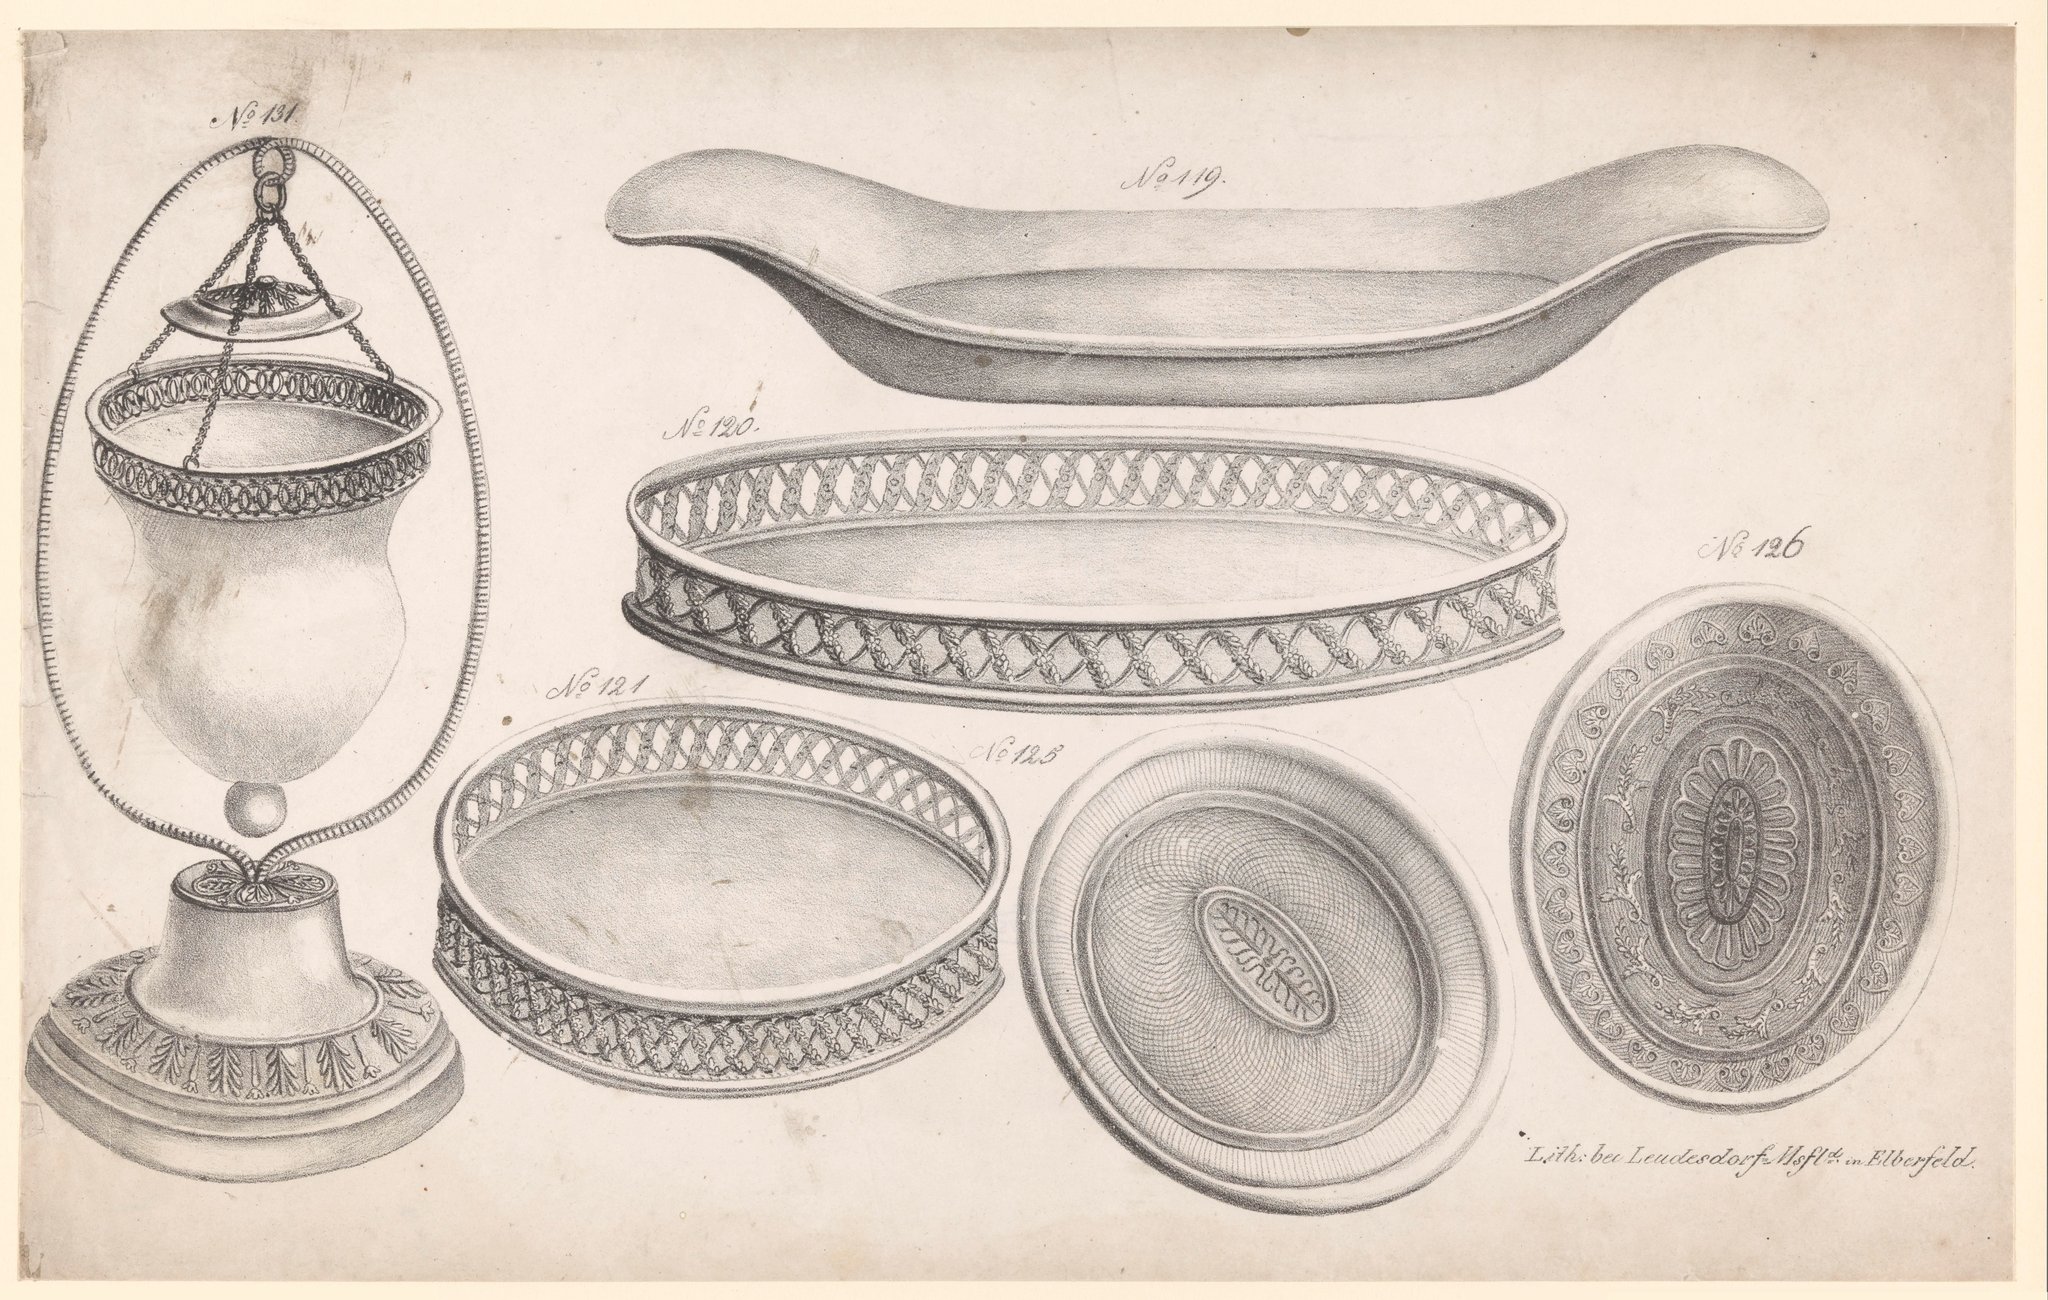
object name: ornament print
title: Empirevoorwerpen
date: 1820-1840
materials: paper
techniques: lithograph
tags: styles in the fine arts (+ later developments), dish, plate, saucer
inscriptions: collector's mark: Lugt 2228, collector's mark: Lugt 2760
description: Ontwerpen voor empirevoorwerpen zoals rechts vijf schalen. Alle objecten zijn genummerd.